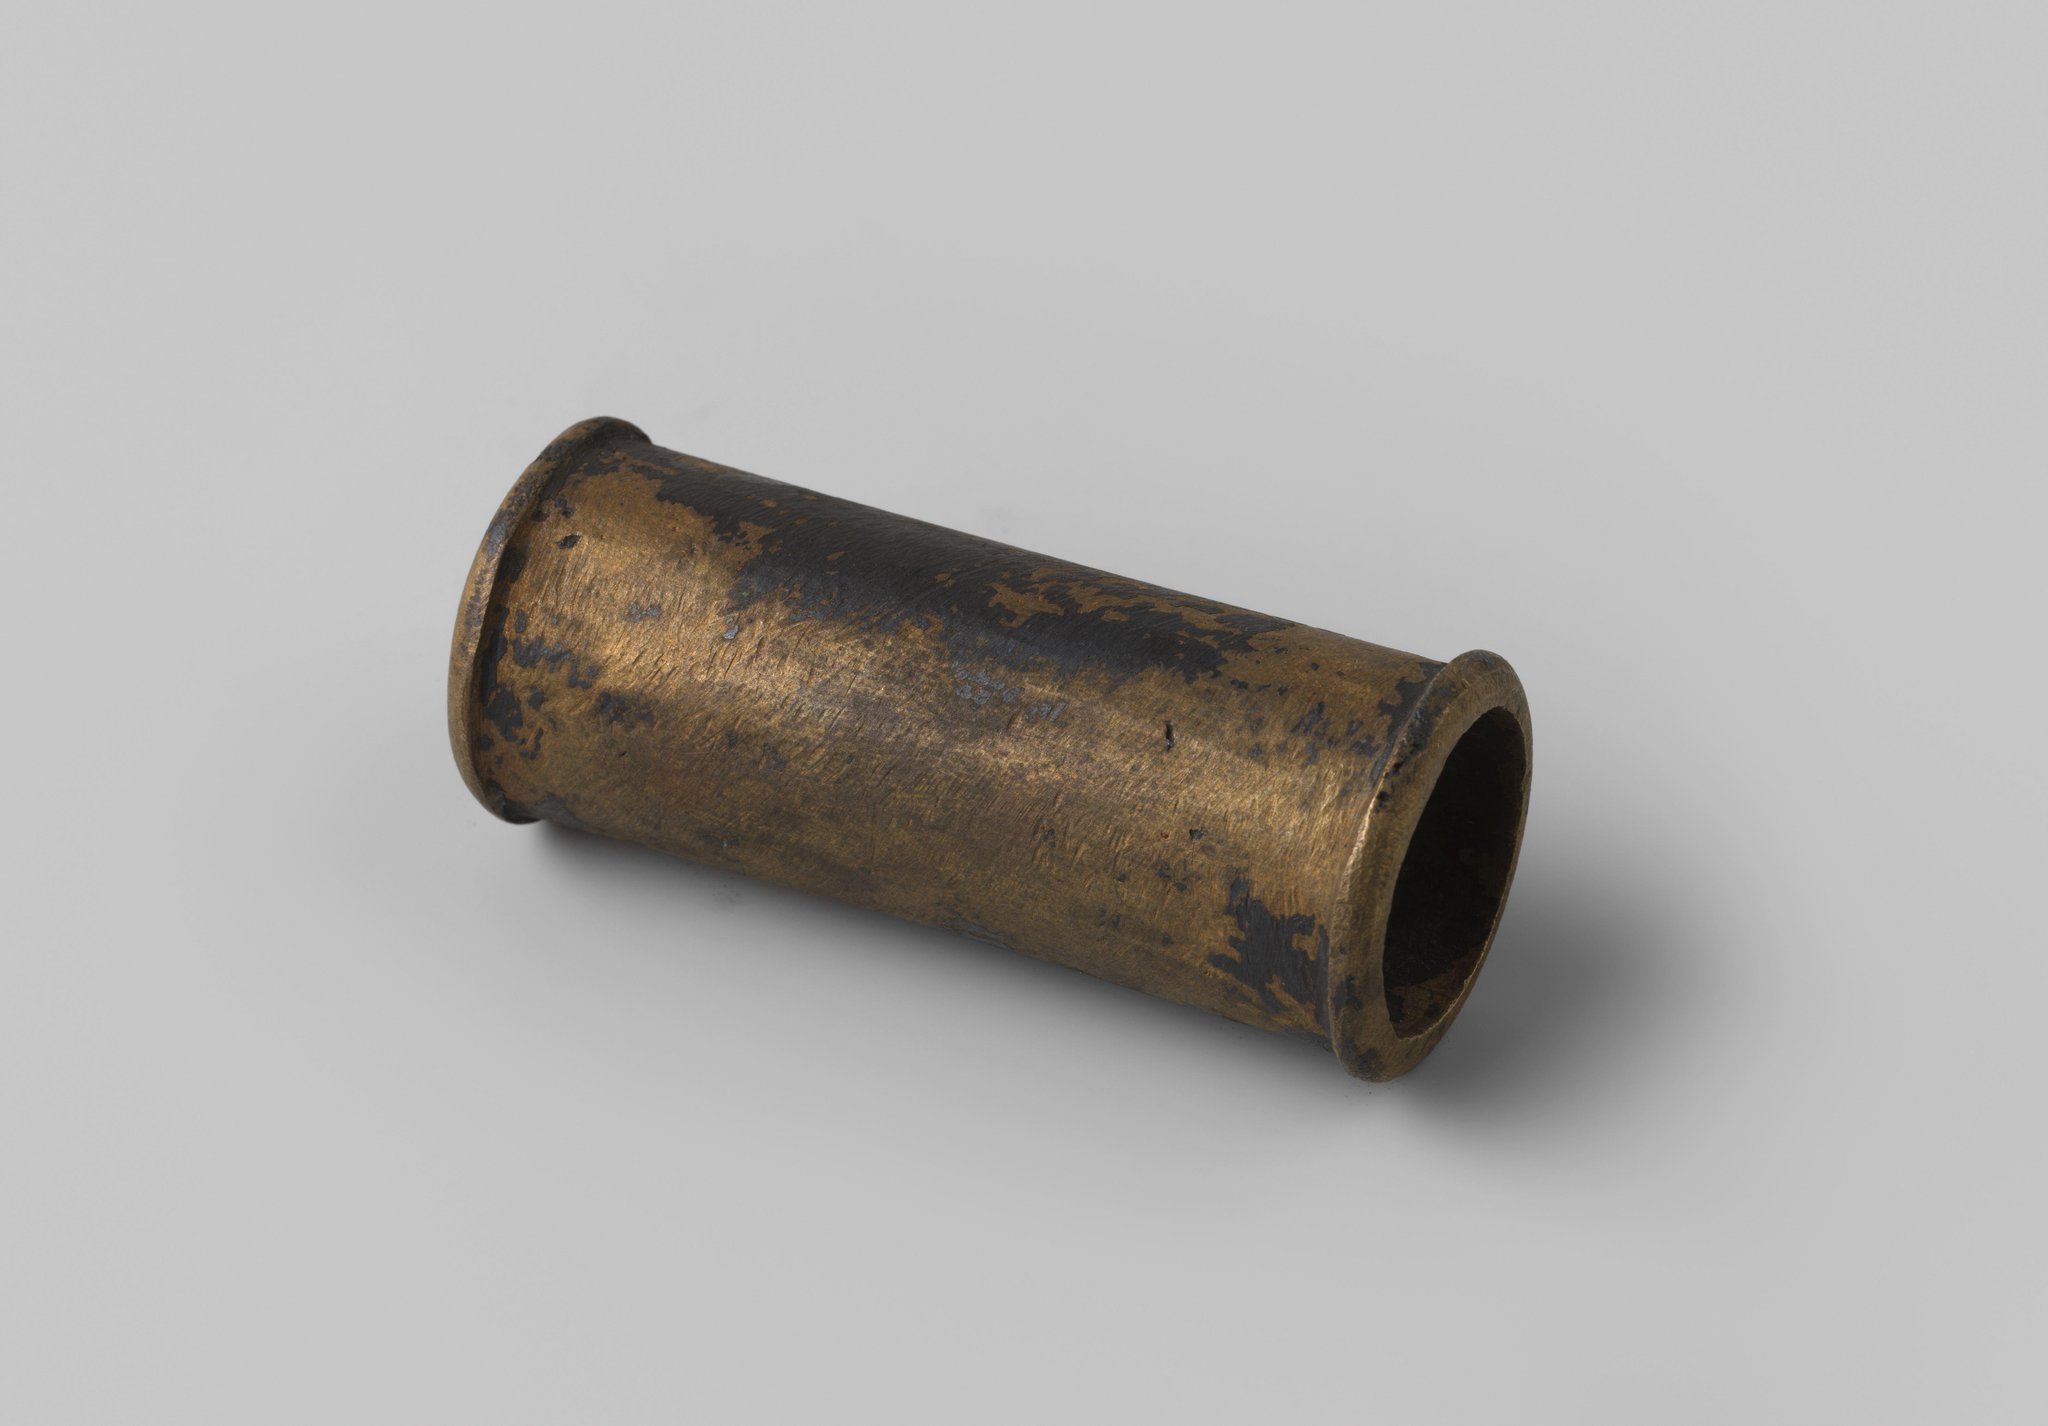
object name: firehose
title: Buis van een brandslang uit het wrak van de Oost-Indiëvaarder Hollandia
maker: Anonymous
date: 1700-1743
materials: copper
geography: netherlands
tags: verenigde oostindische compagnie, hollandia (schip), annet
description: Fire engine, firehose, tube; straight, circular, raised rims at both ends.